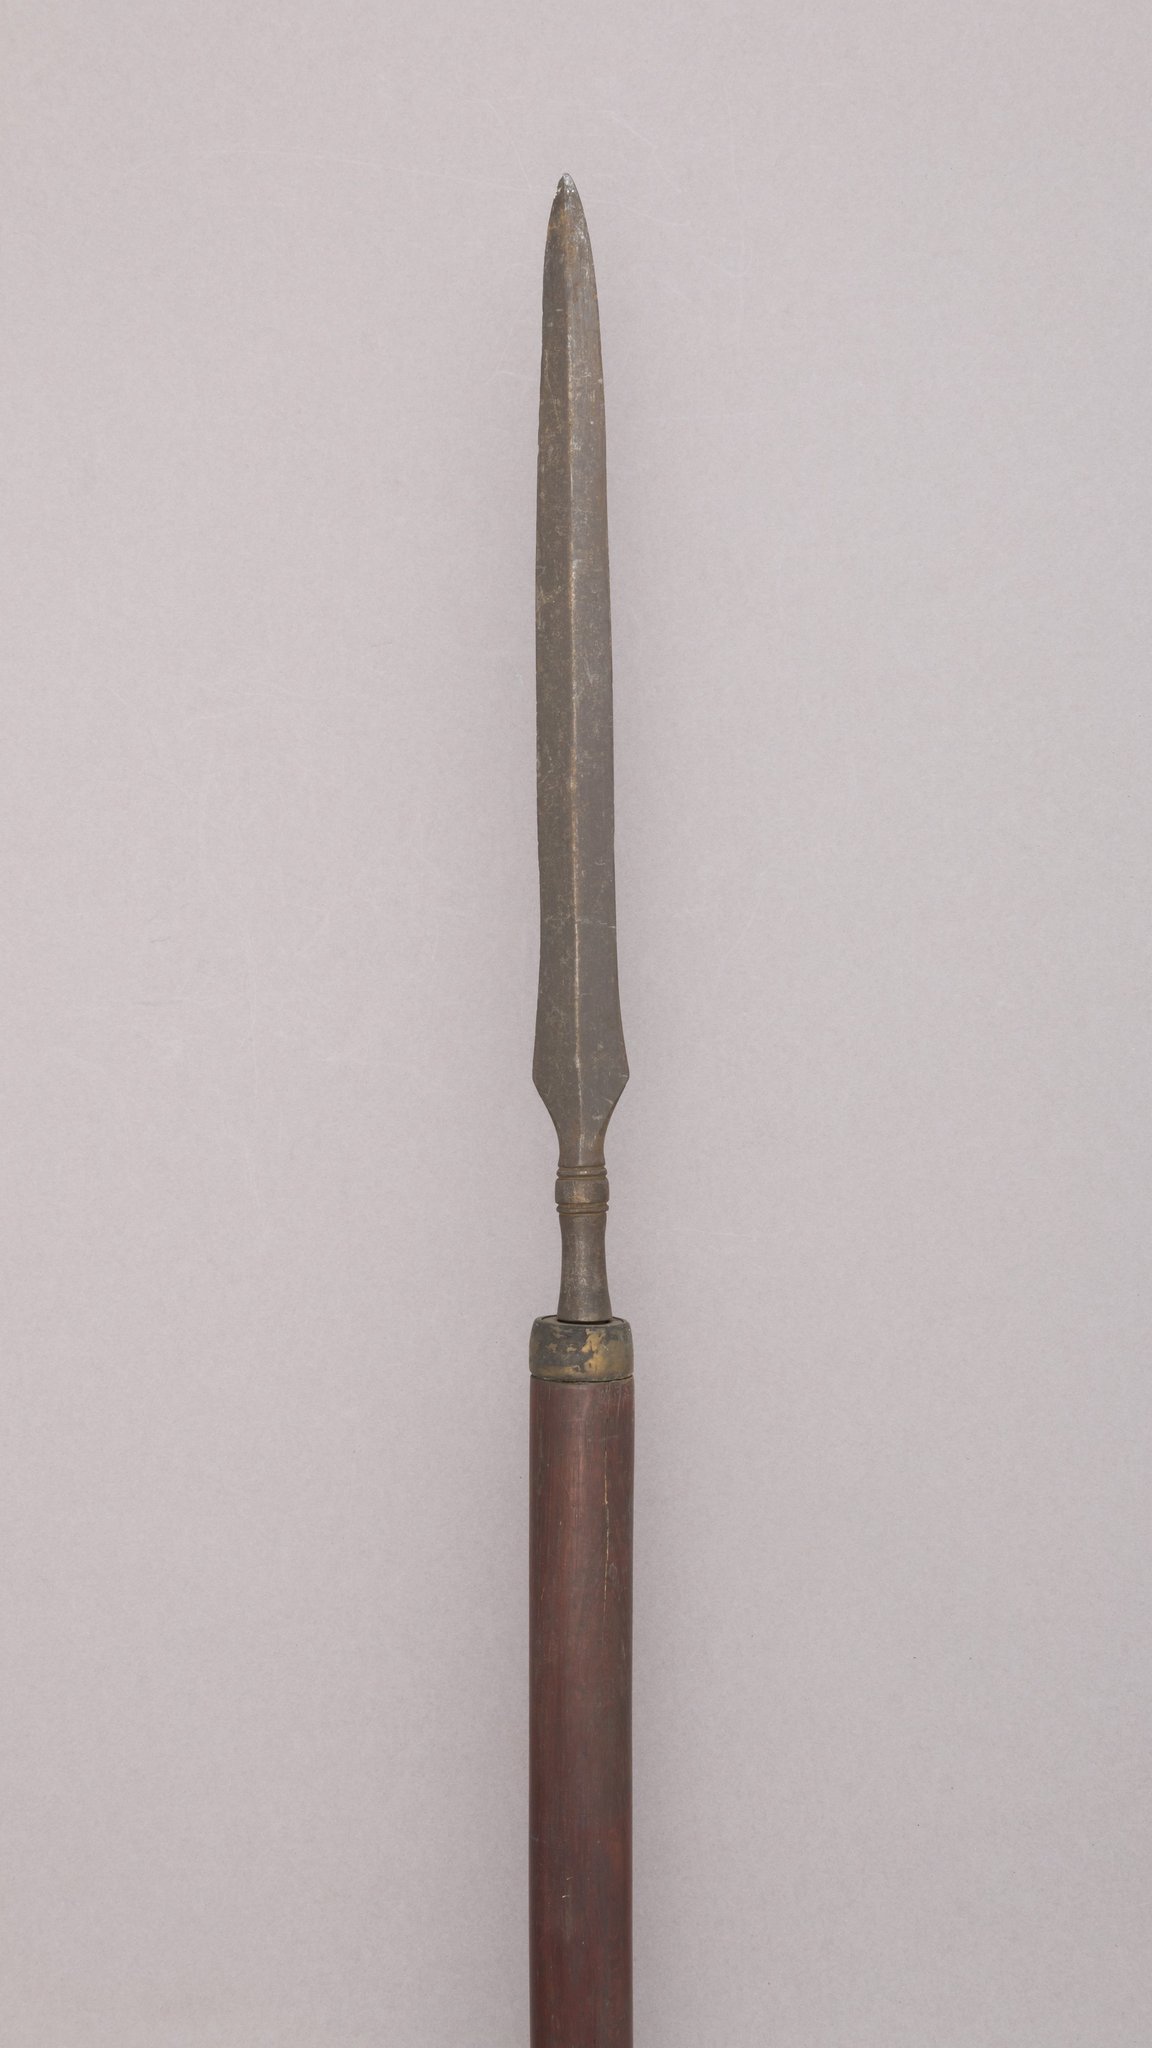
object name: spear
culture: bornean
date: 1701-1900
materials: wood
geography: borneo